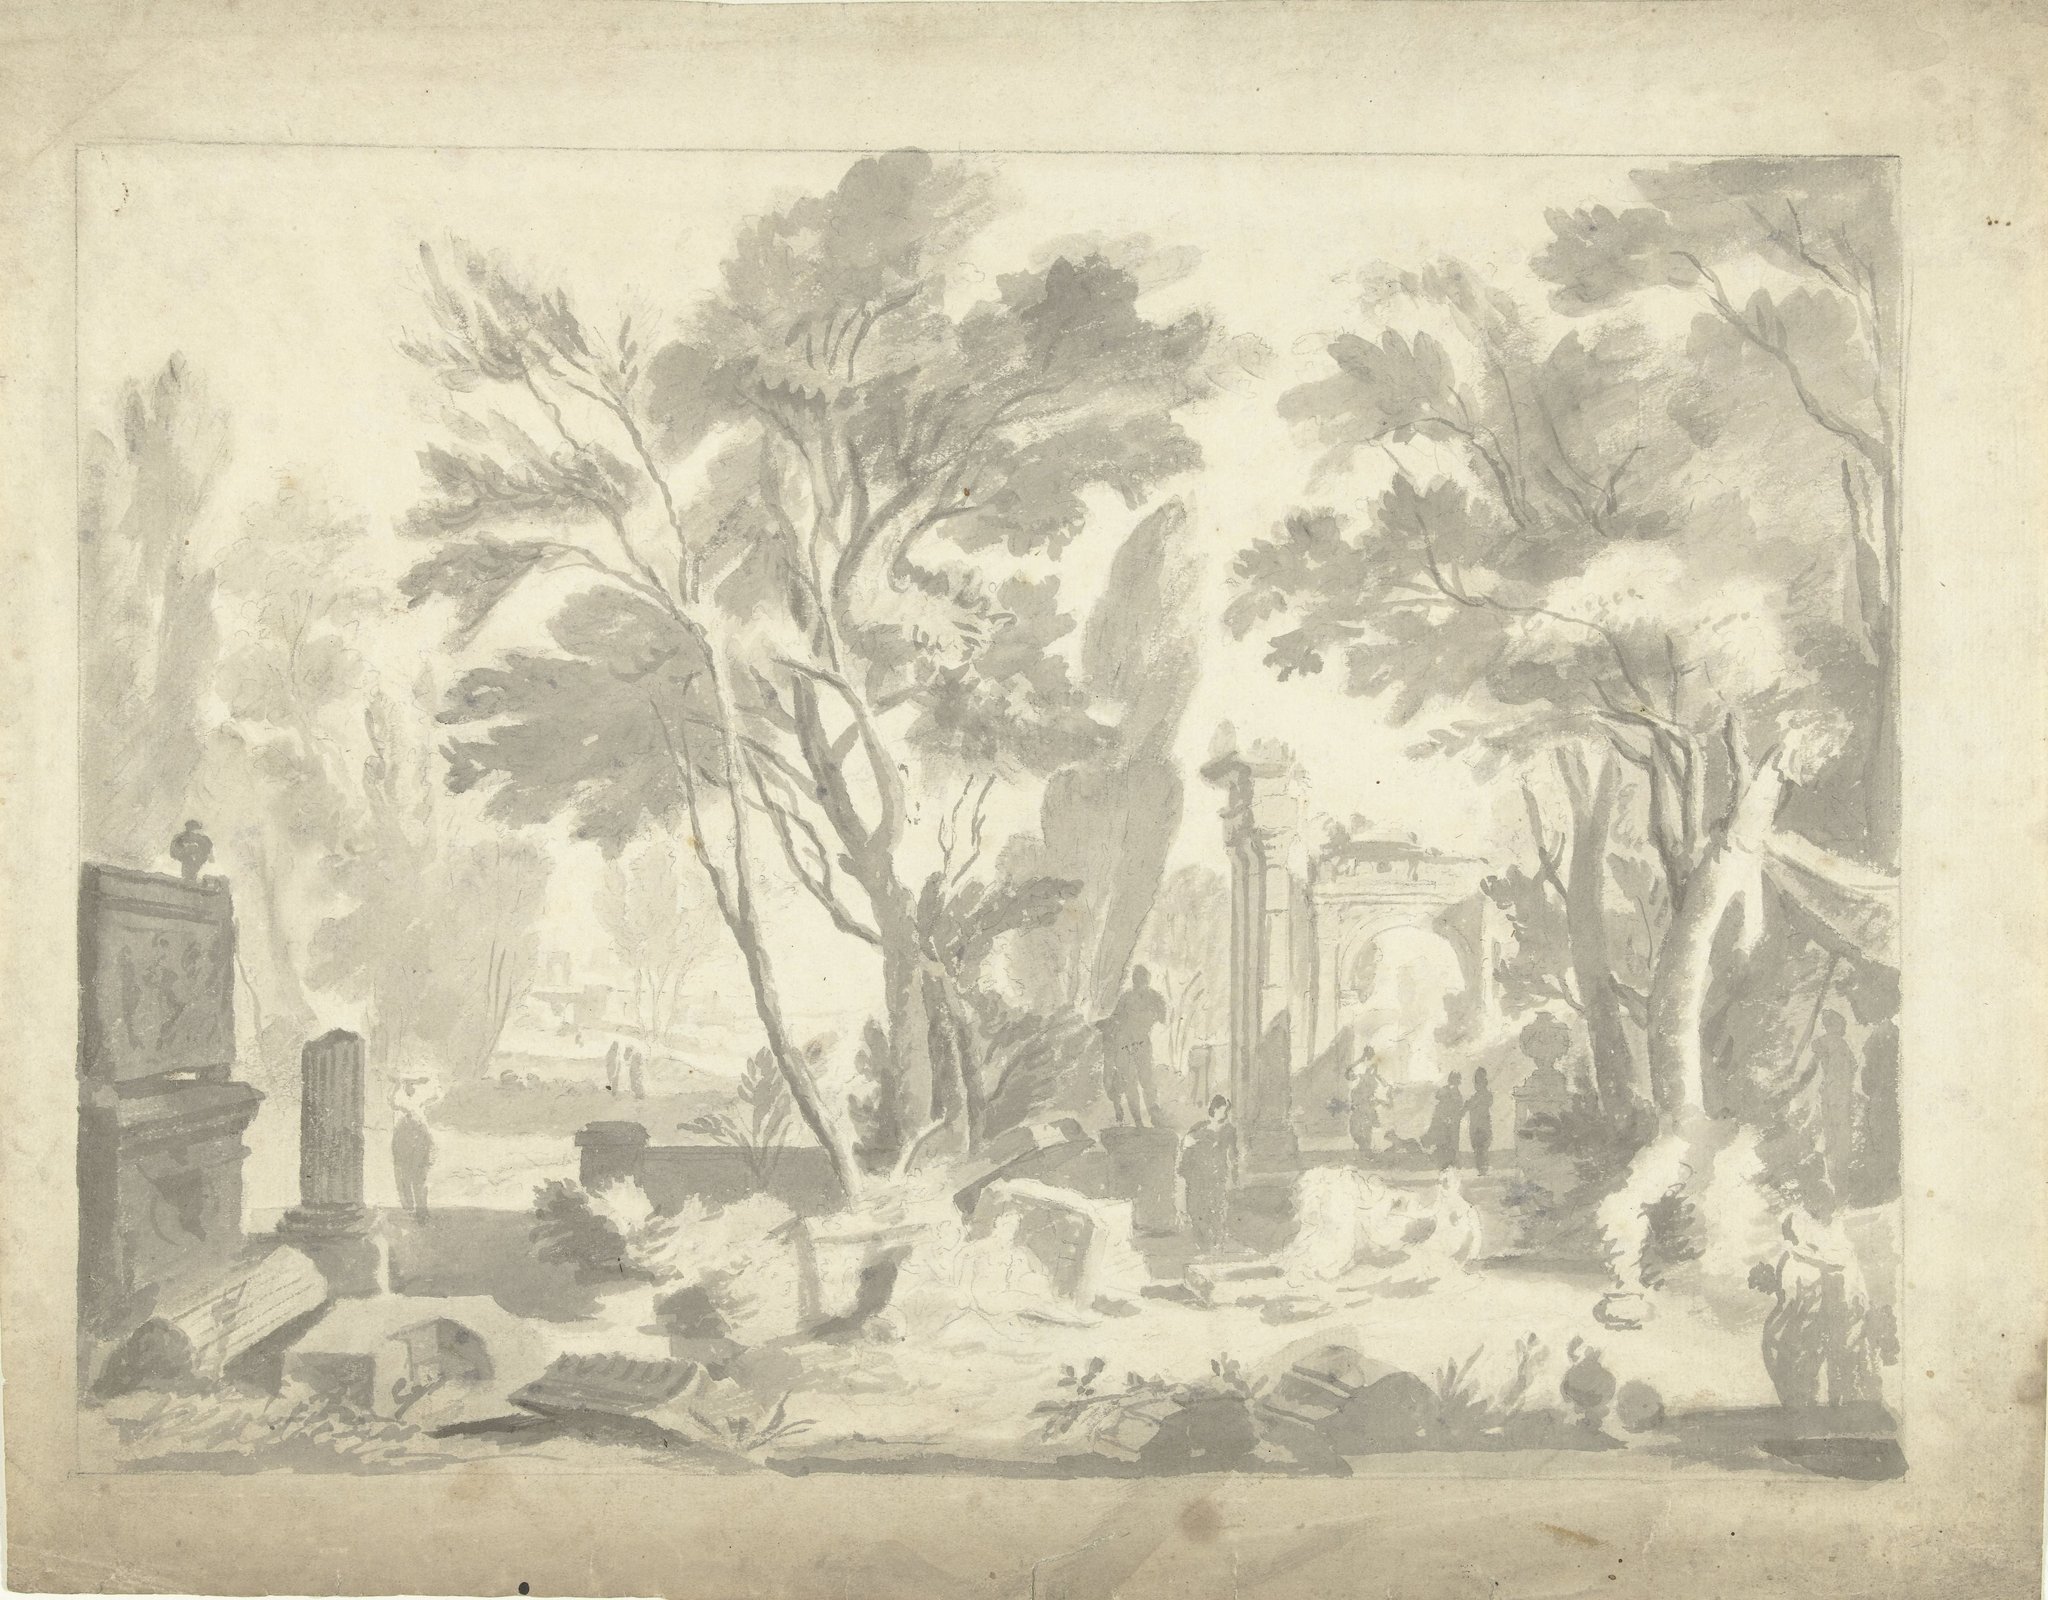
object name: design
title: Landschap met ruïnes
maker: dionys van nijmegen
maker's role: draughtsman, painter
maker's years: 1705-1798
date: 1715-1798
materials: paper, pencil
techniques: brush